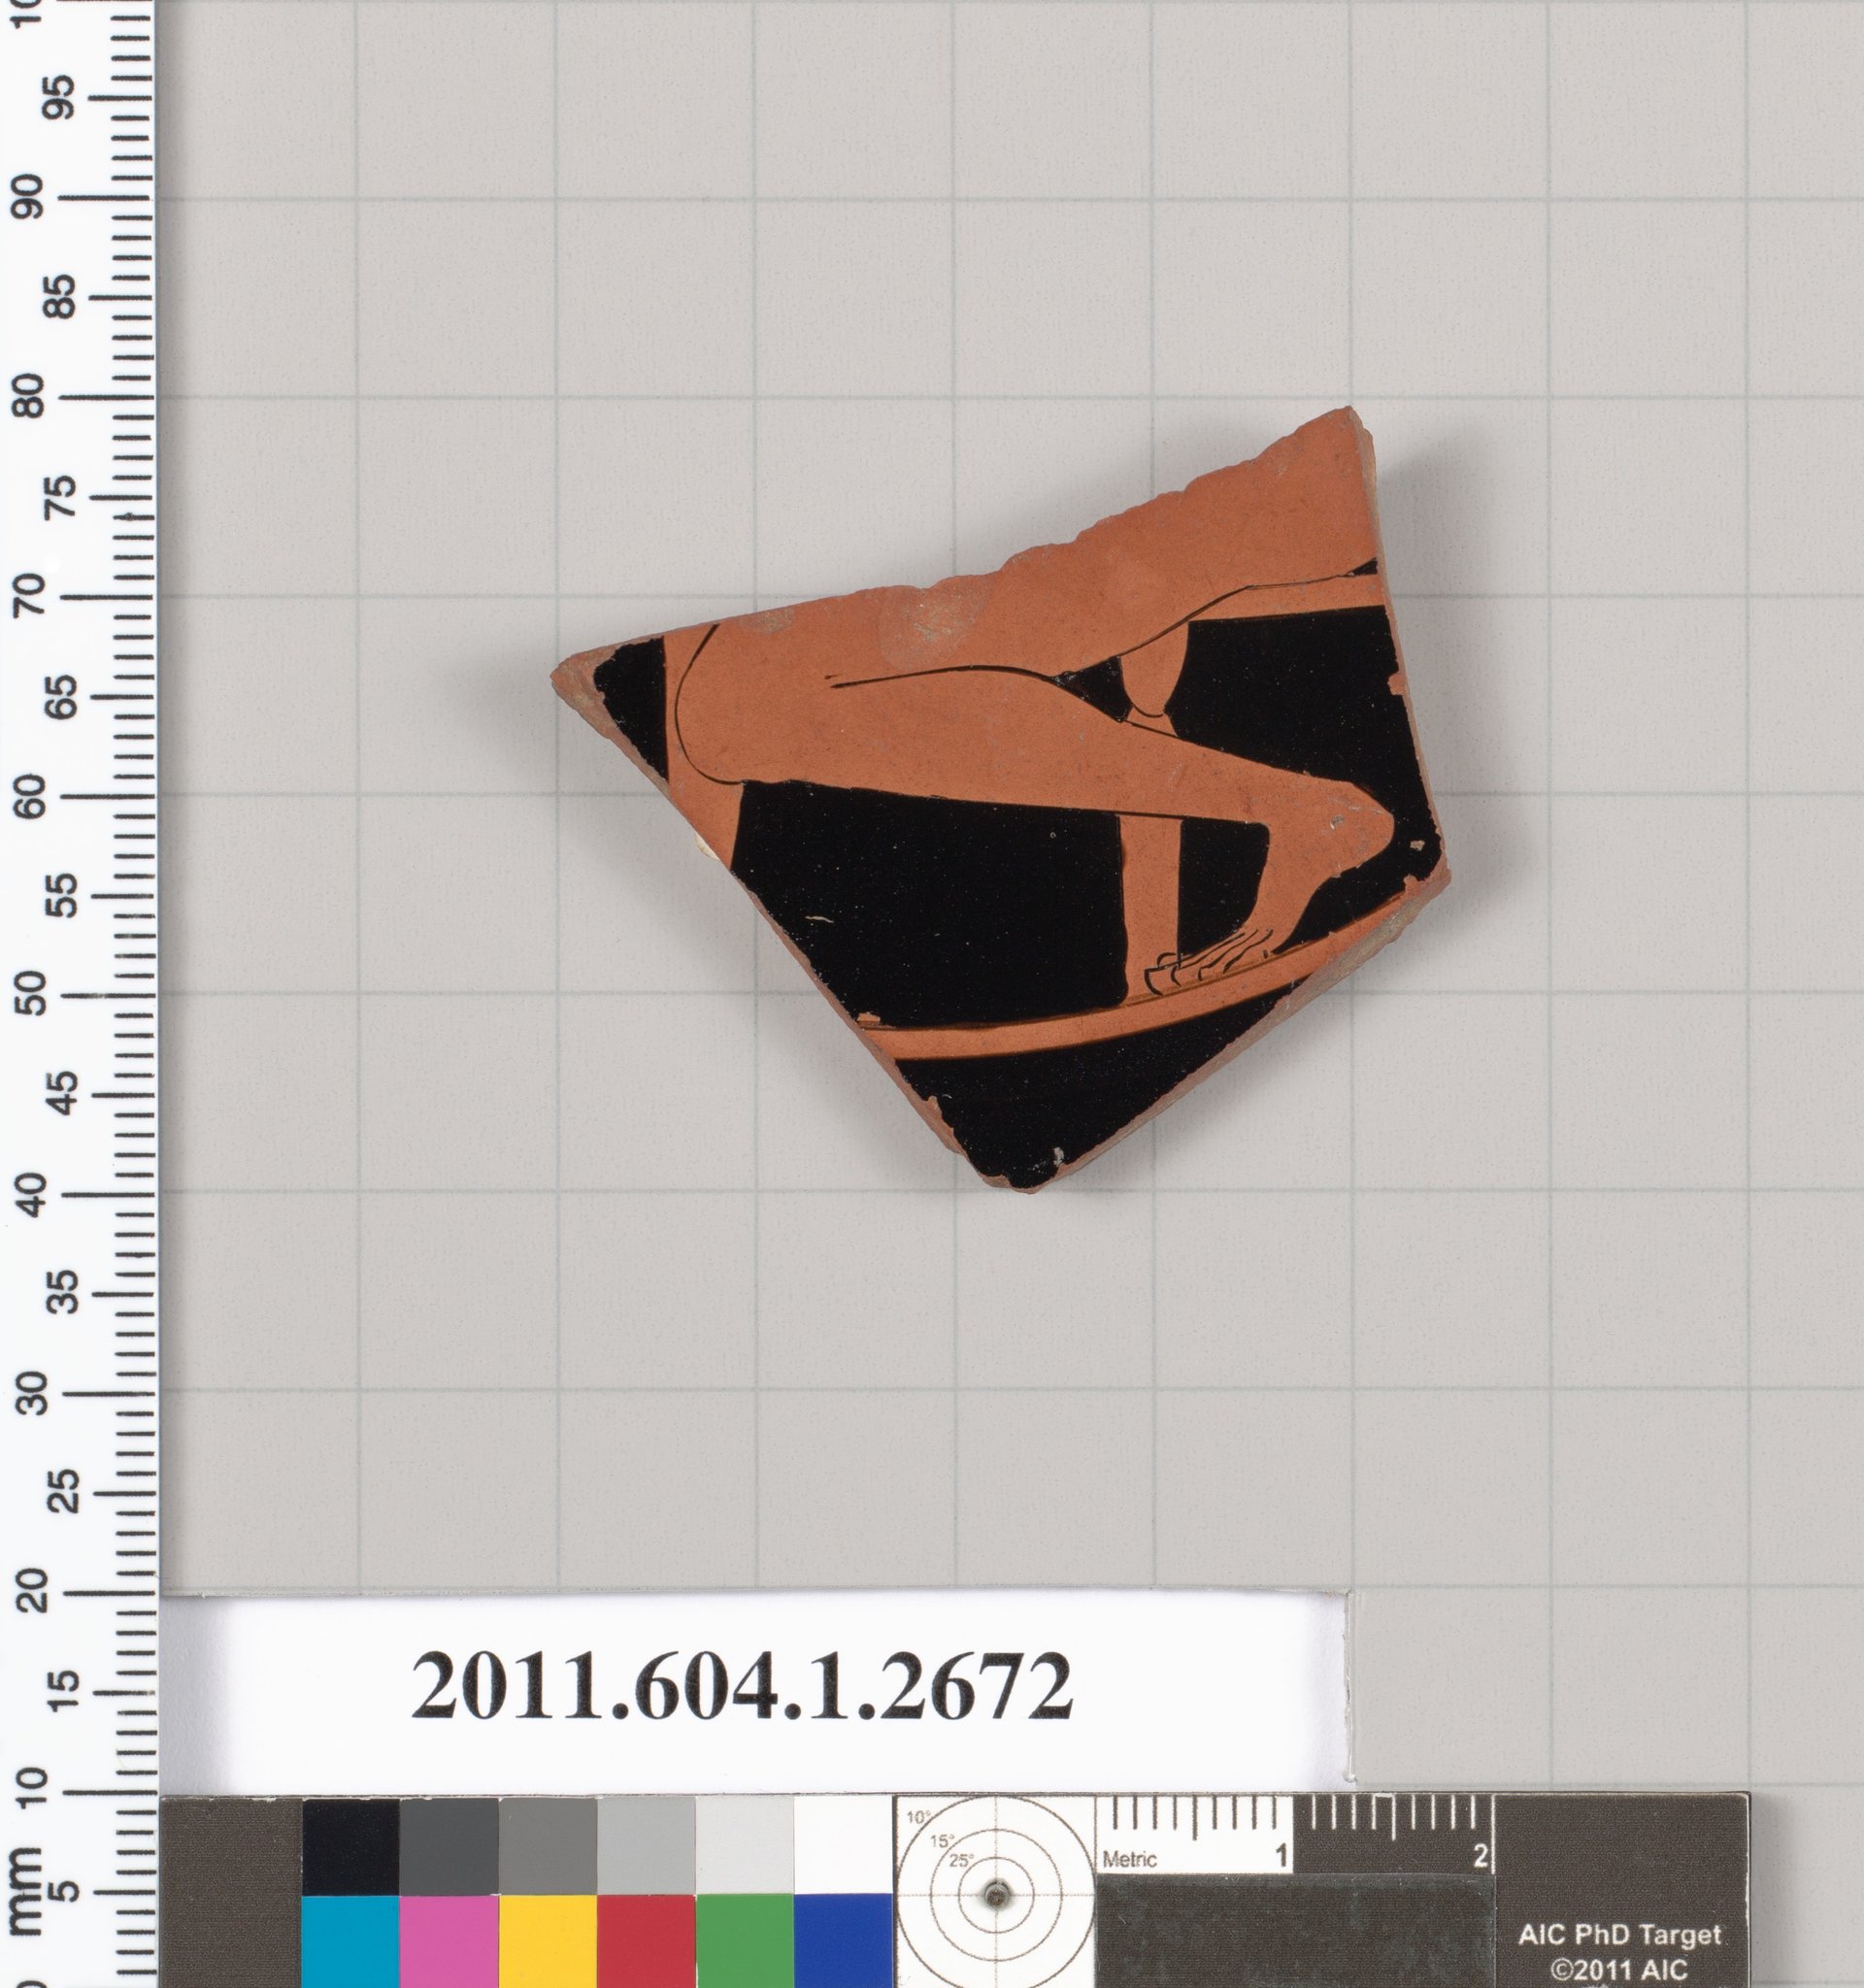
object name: kylix fragment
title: Terracotta fragment of a kylix (drinking cup)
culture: greek, attic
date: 500-480 BCE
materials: terracotta